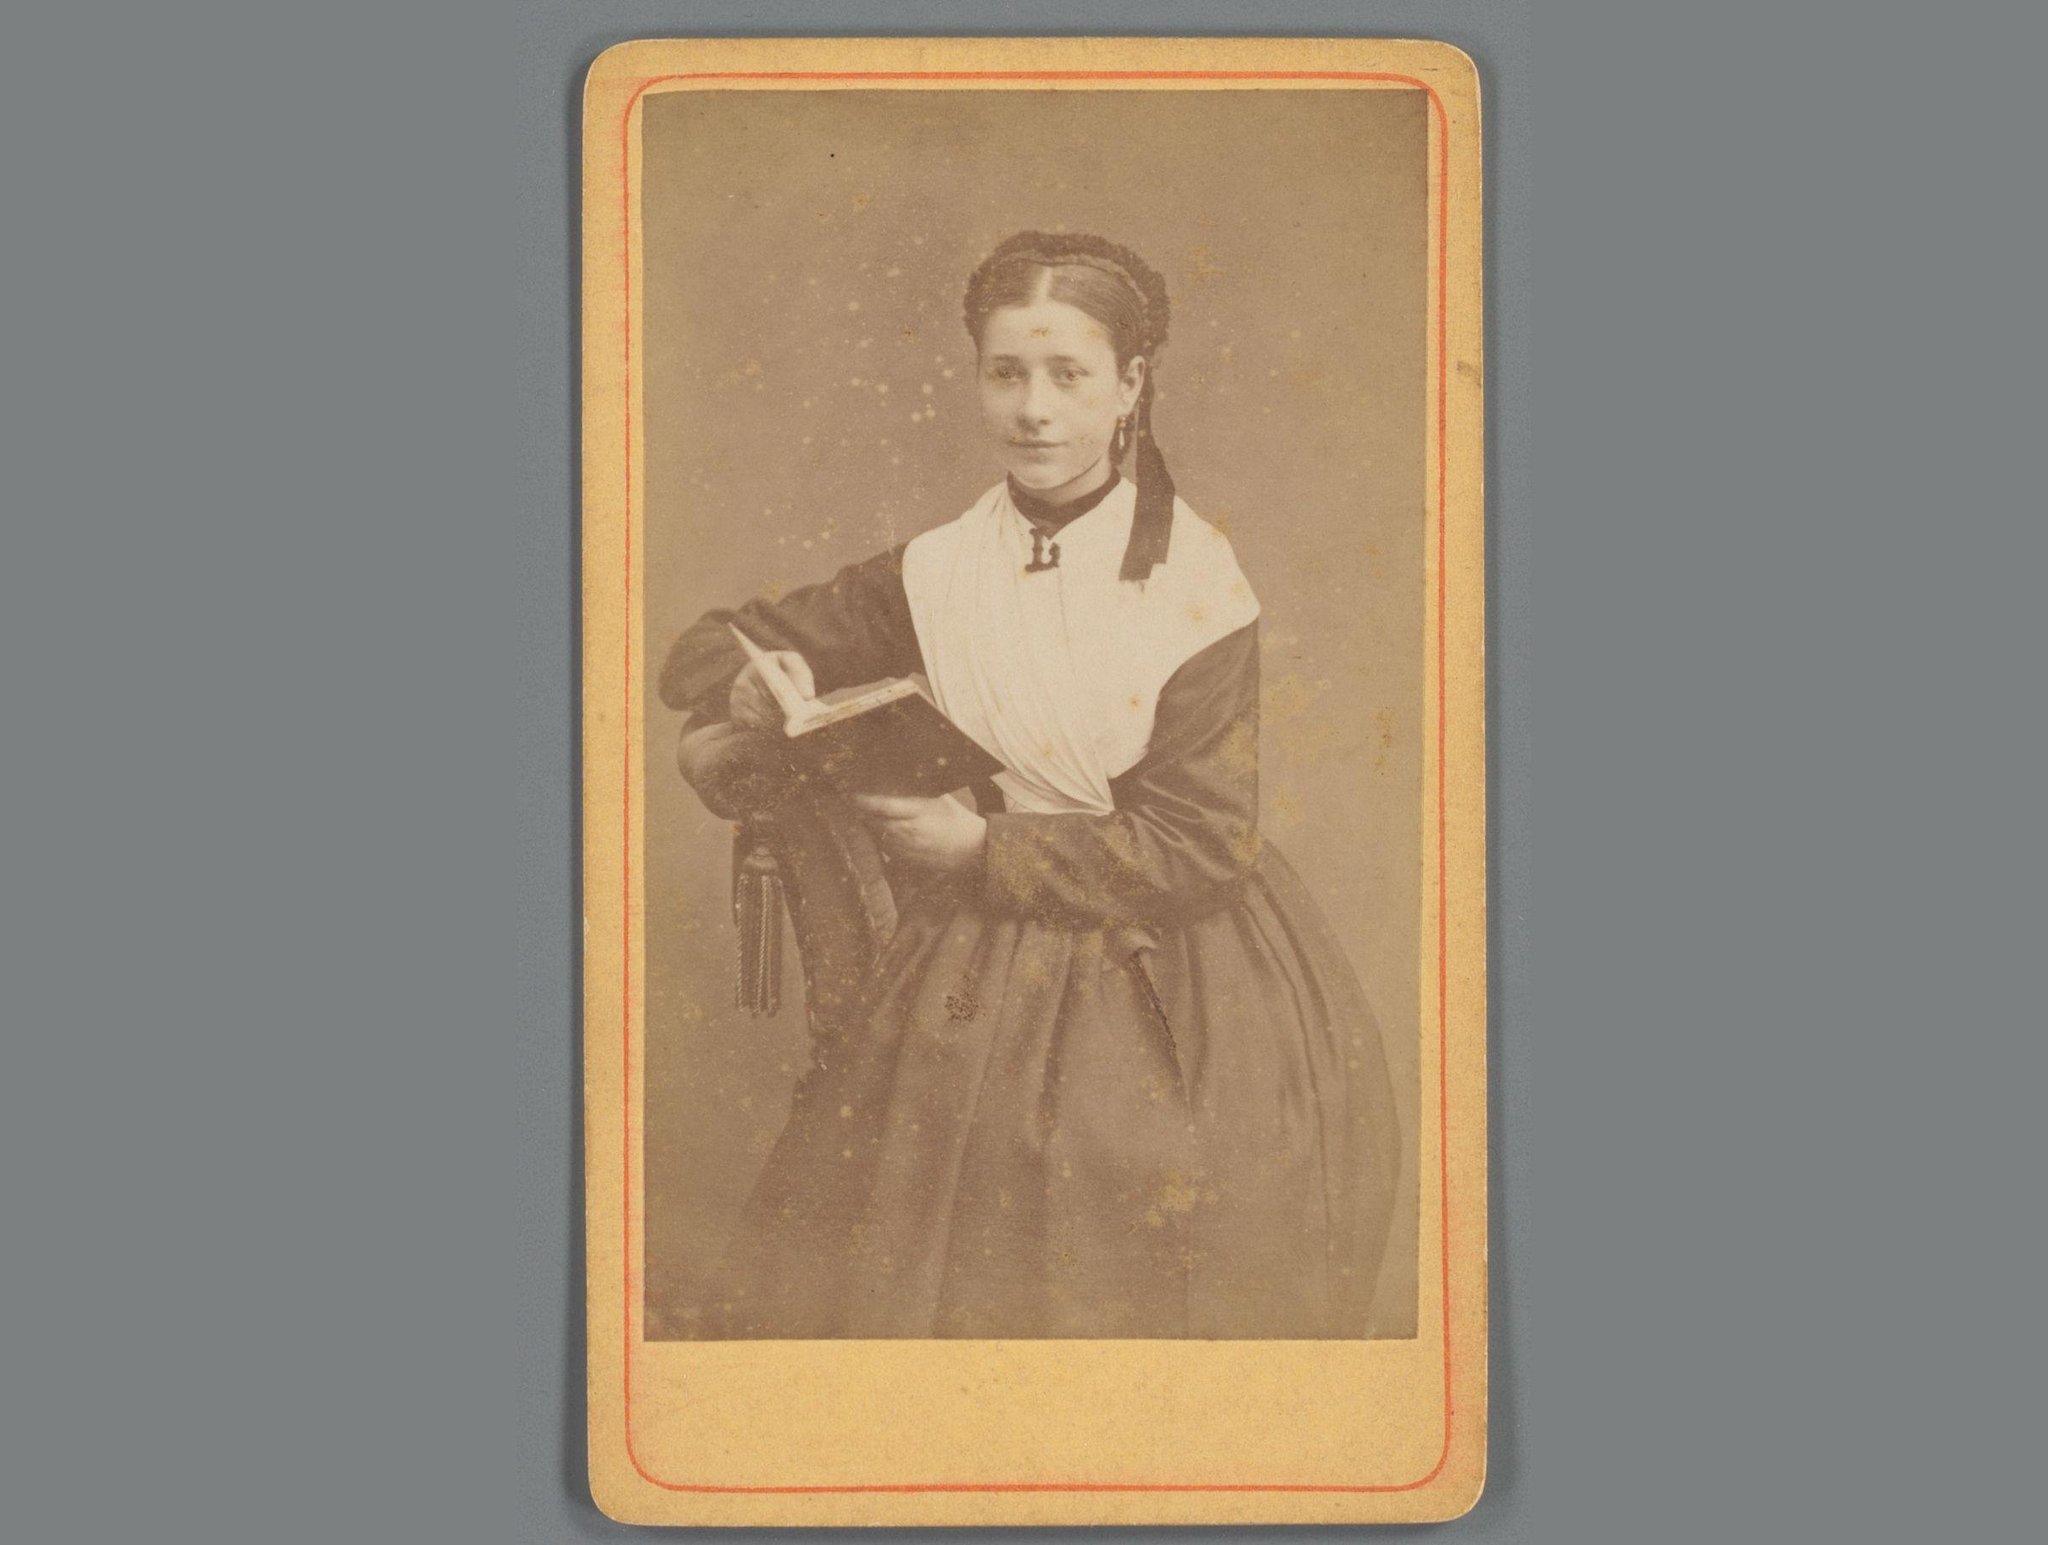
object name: carte de visite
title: Portret van een onbekende jonge vrouw met een boek uit de familie en de kring van Eugene van Delden en Belle van Delden-Denninghof Stelling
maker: Anonymous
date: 1855-1875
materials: cardboard, paper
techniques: albumen print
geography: netherlands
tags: adolescent, young woman, maiden, reading, historical persons not known by name - bb - woman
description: Portret uit de kring van Eugene van Delden (Hartapoera, 1865 - Den Haag, 1954) en Belle van Delden-Denninghof Stelling (Batavia, 1870 - Den Haag, 1947).